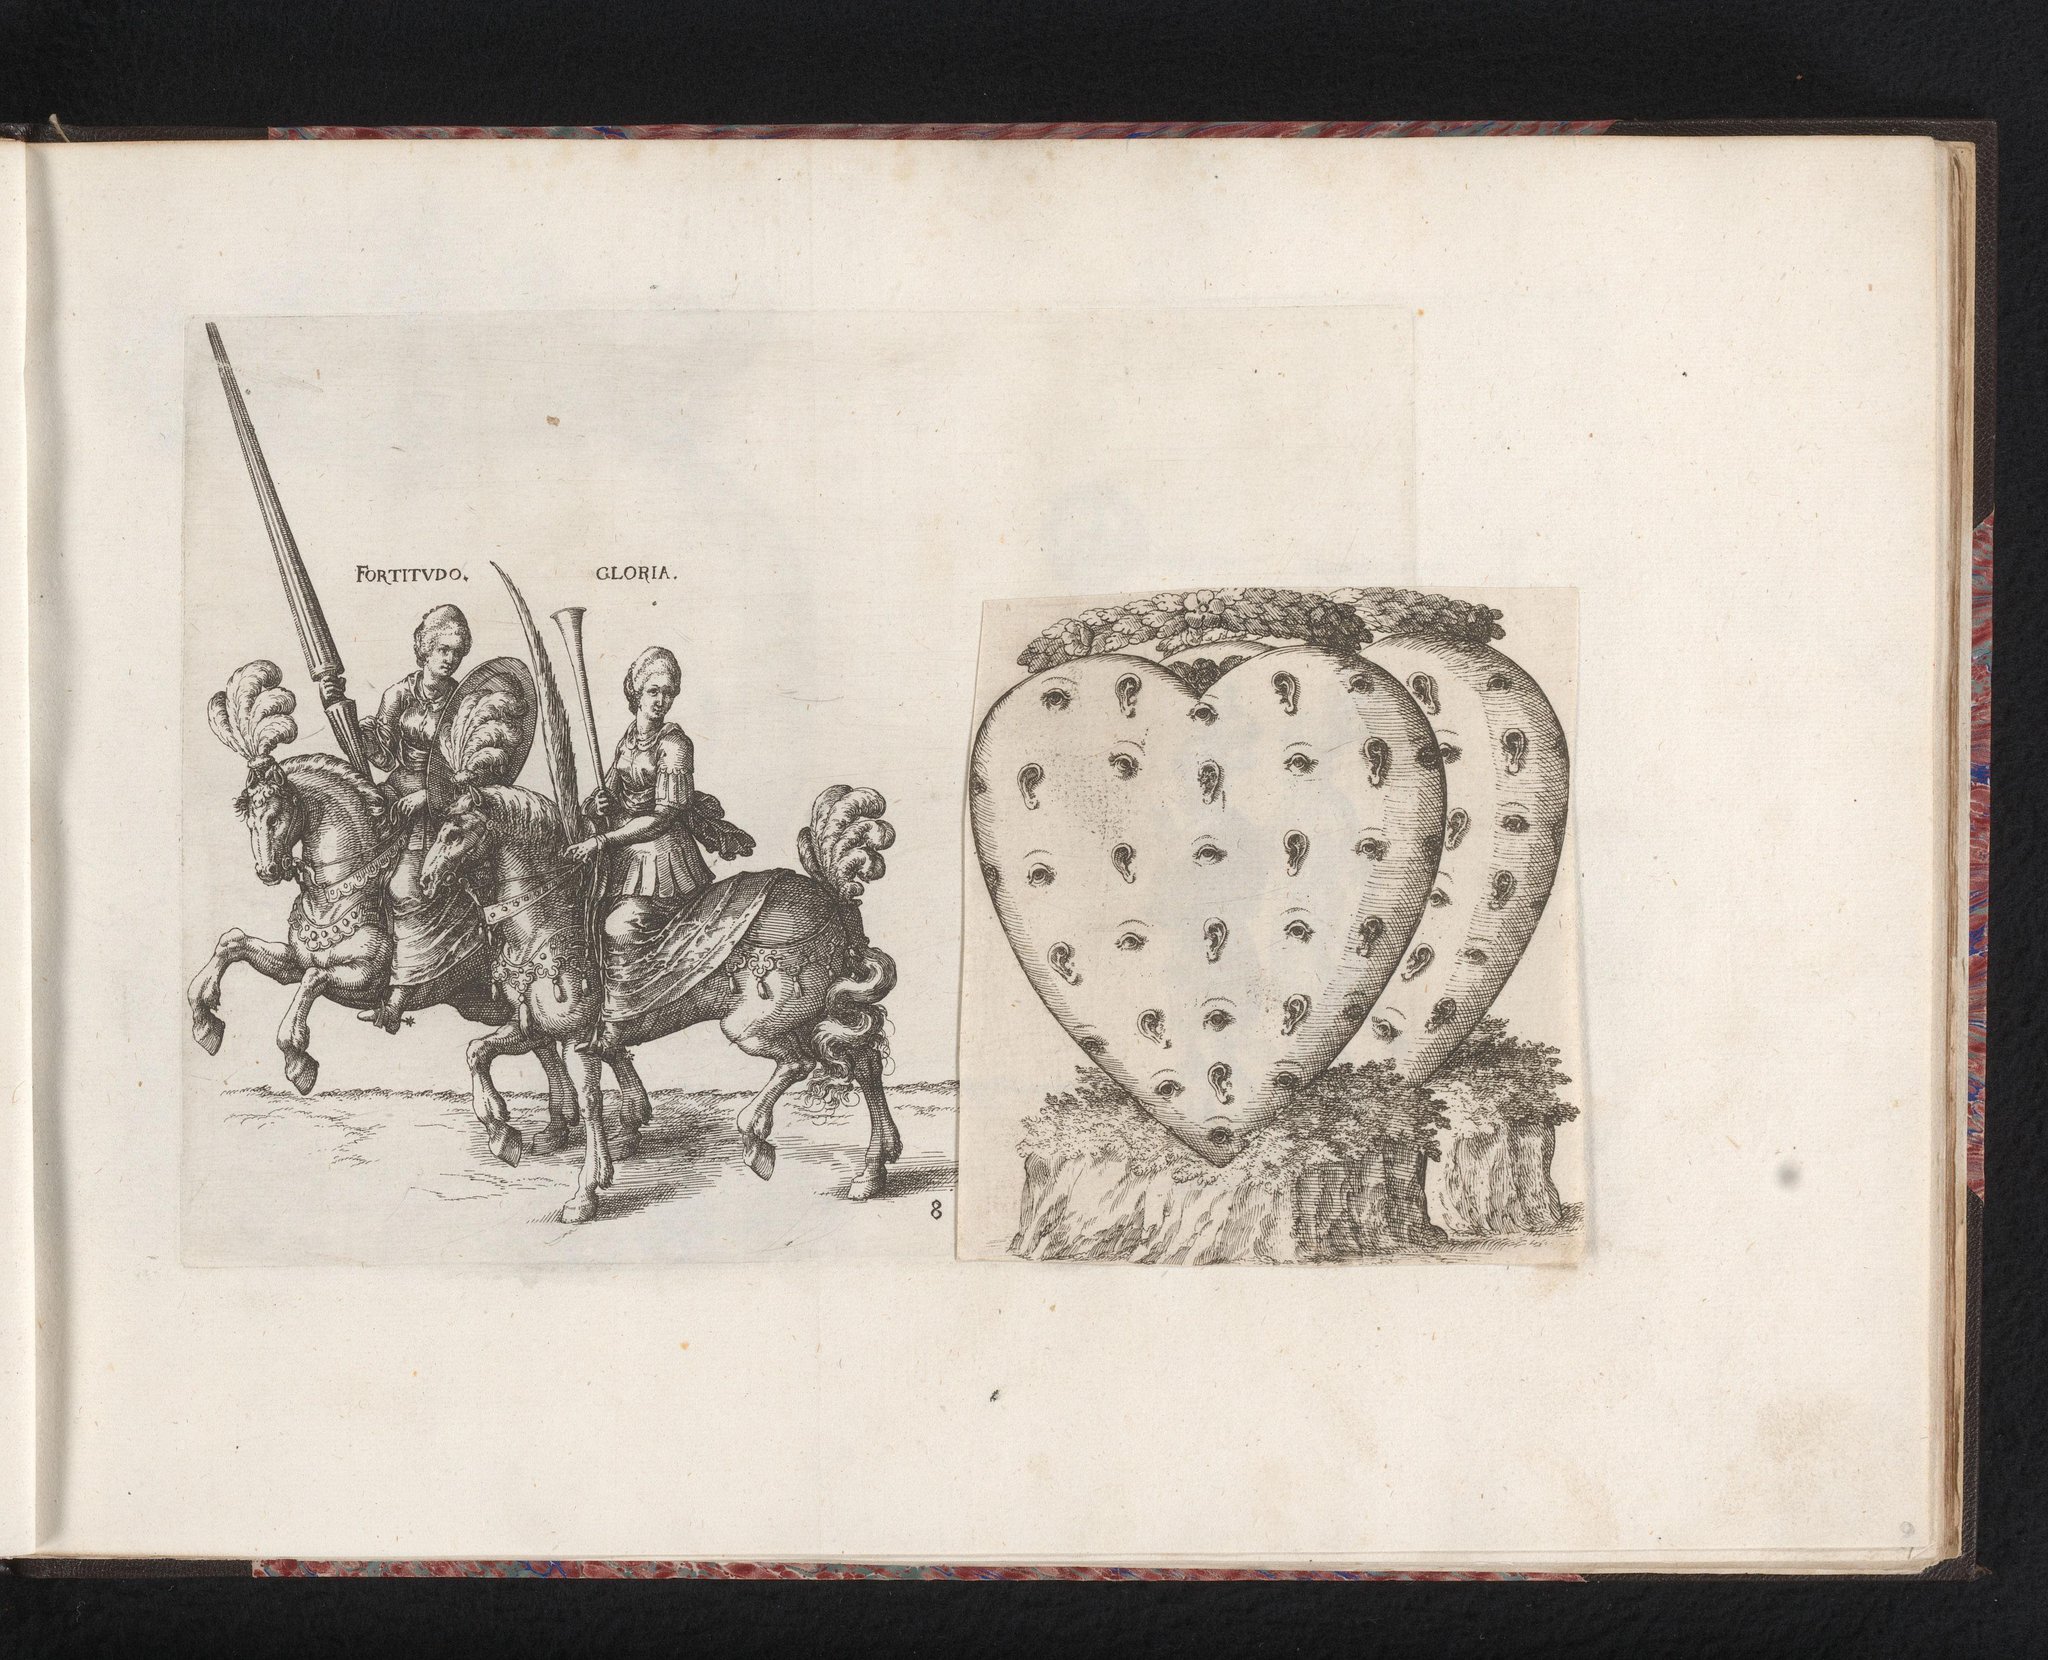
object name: album leaf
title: Personificaties van Moed (Fortitudo) en Roem (Gloria) te paard met twee soldaten en een embleem van twee gelauwerde harten met oren en ogen op rotsen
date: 1618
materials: paper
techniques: etching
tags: riding a horse, ass, or mule; rider, horseman, fortitude, 'fortitudo' ~ one of the four cardinal virtues - mm - triumph, heart symbolism, private soldier, performance in the open air (pleasure fair), honour, glory; 'ampiezza della gloria', 'gloria', 'gloria de prencipi', 'gloria & honore', 'honore', 'sublimatà della gloria' (ripa)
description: Mogelijk staan de harten met ogen en oren voor het verschil tussen het uiterlijk en het innerlijke of zijn een verwijzing naar Efeziërs 1:18, waarin het openstellen van het hart de verlichte zienswijze is. Deze prent is onderdeel van een serie.